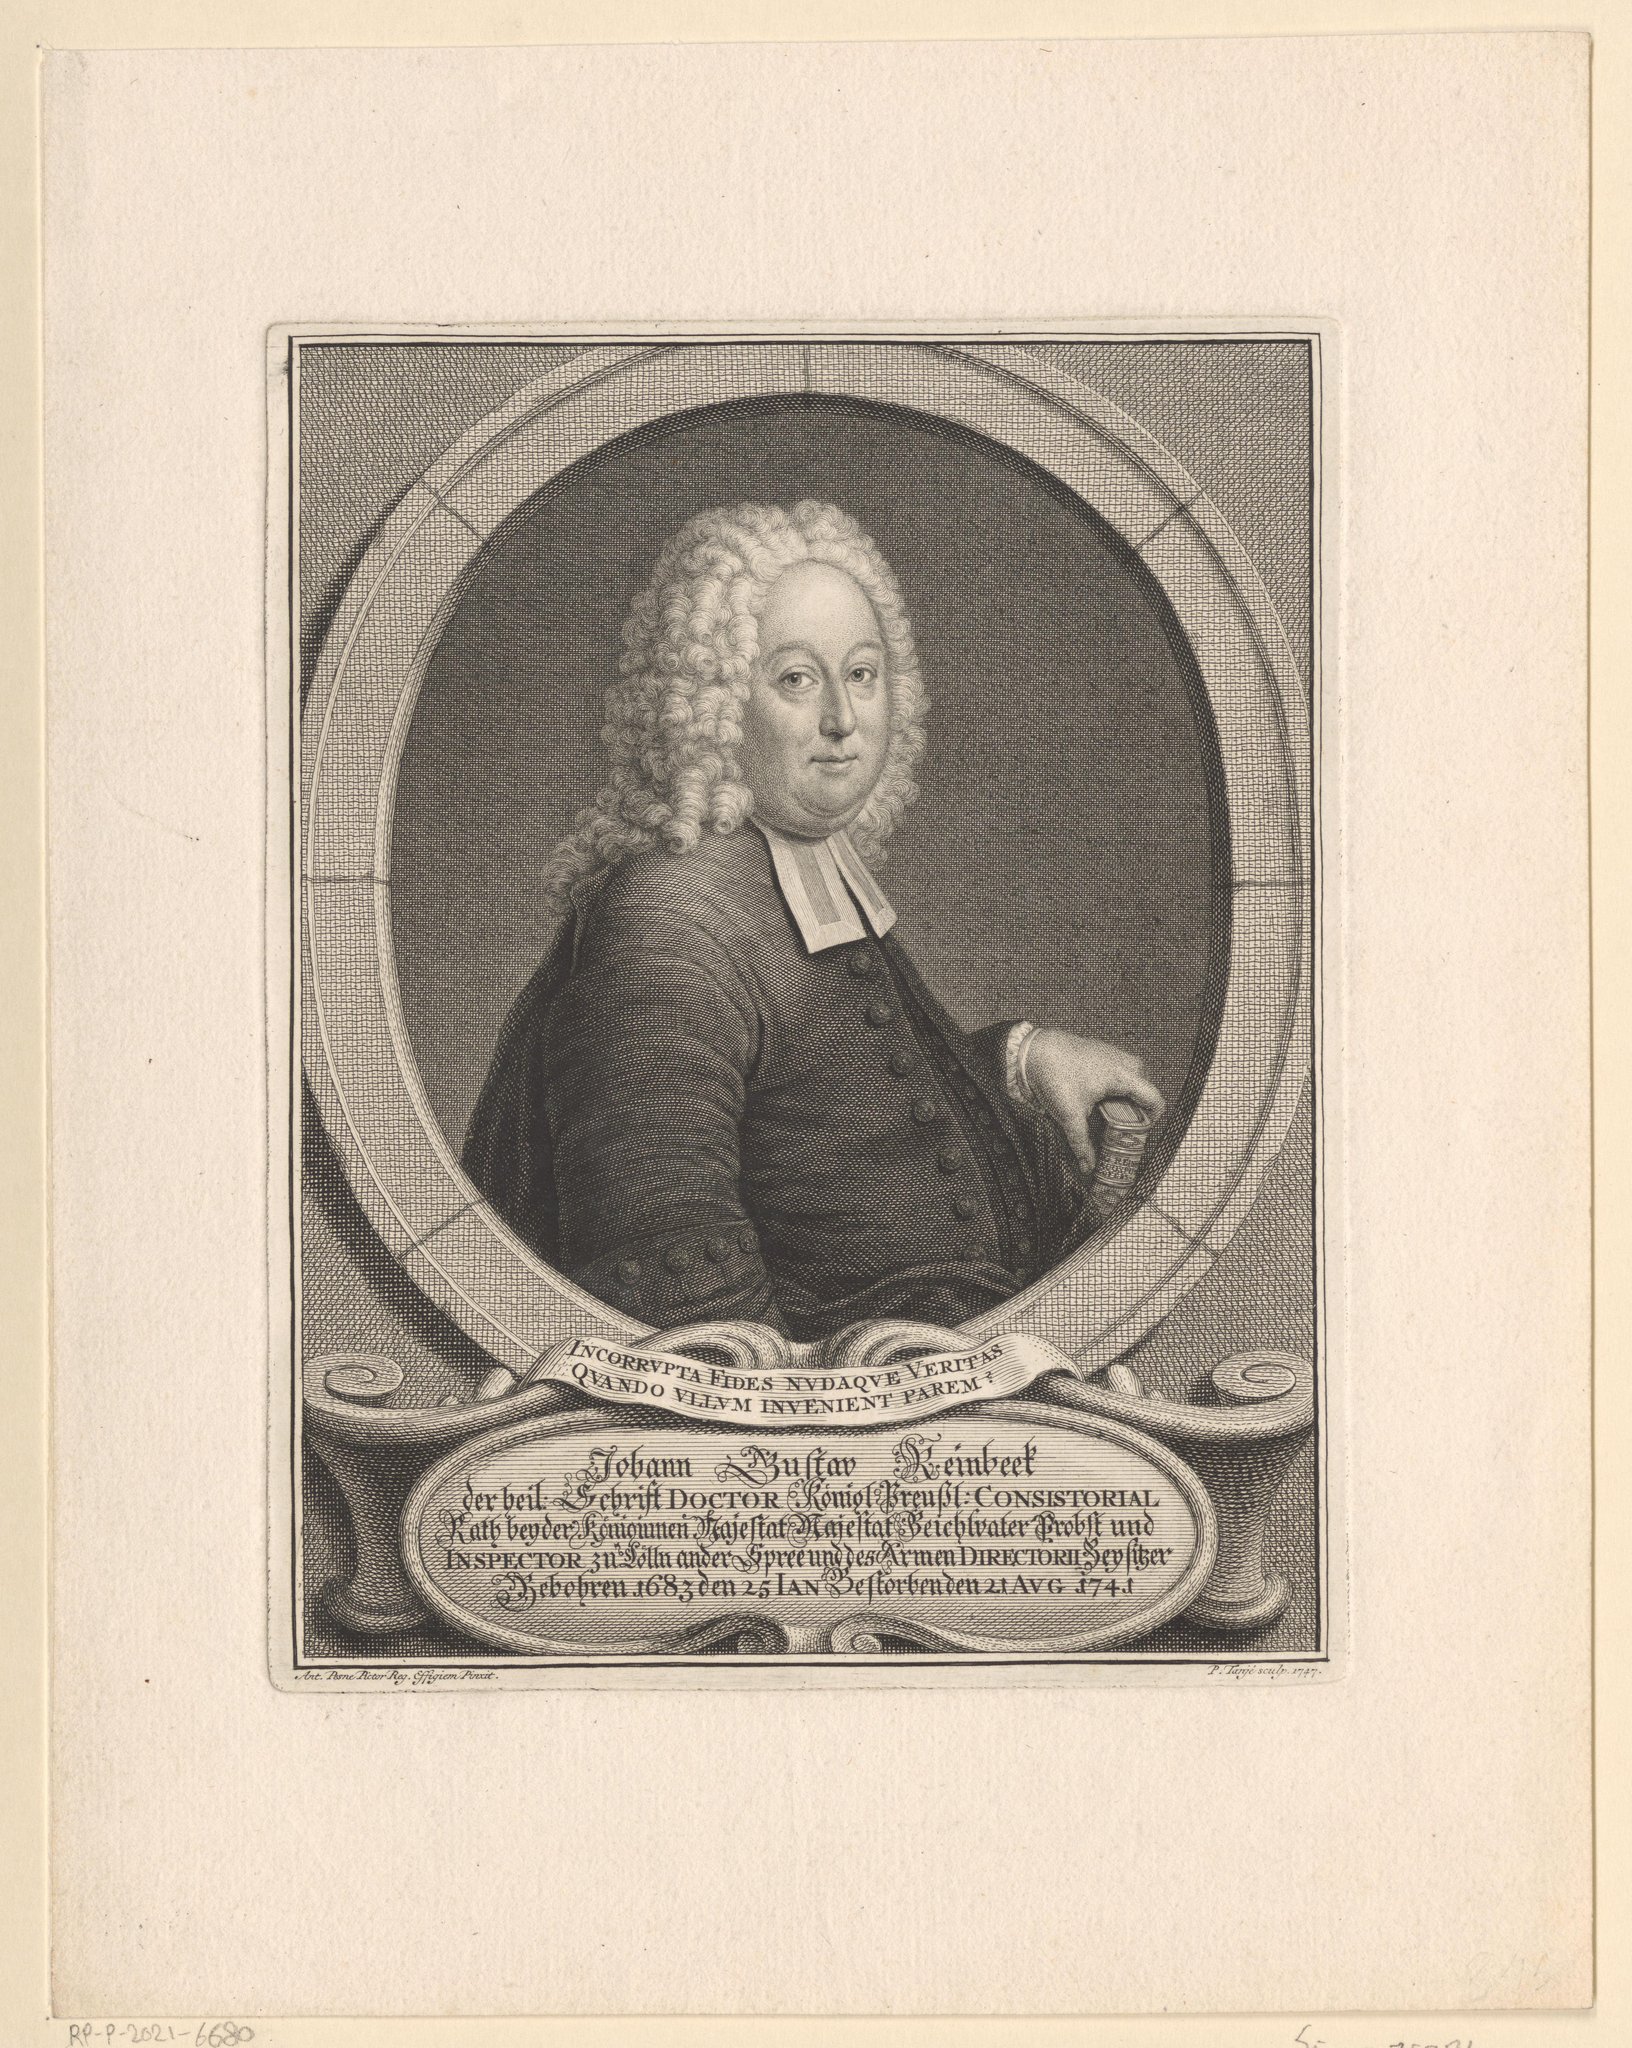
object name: print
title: Portret van Johann Gustav Reinbeck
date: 1747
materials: paper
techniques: engraving, etching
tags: historical persons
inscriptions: date